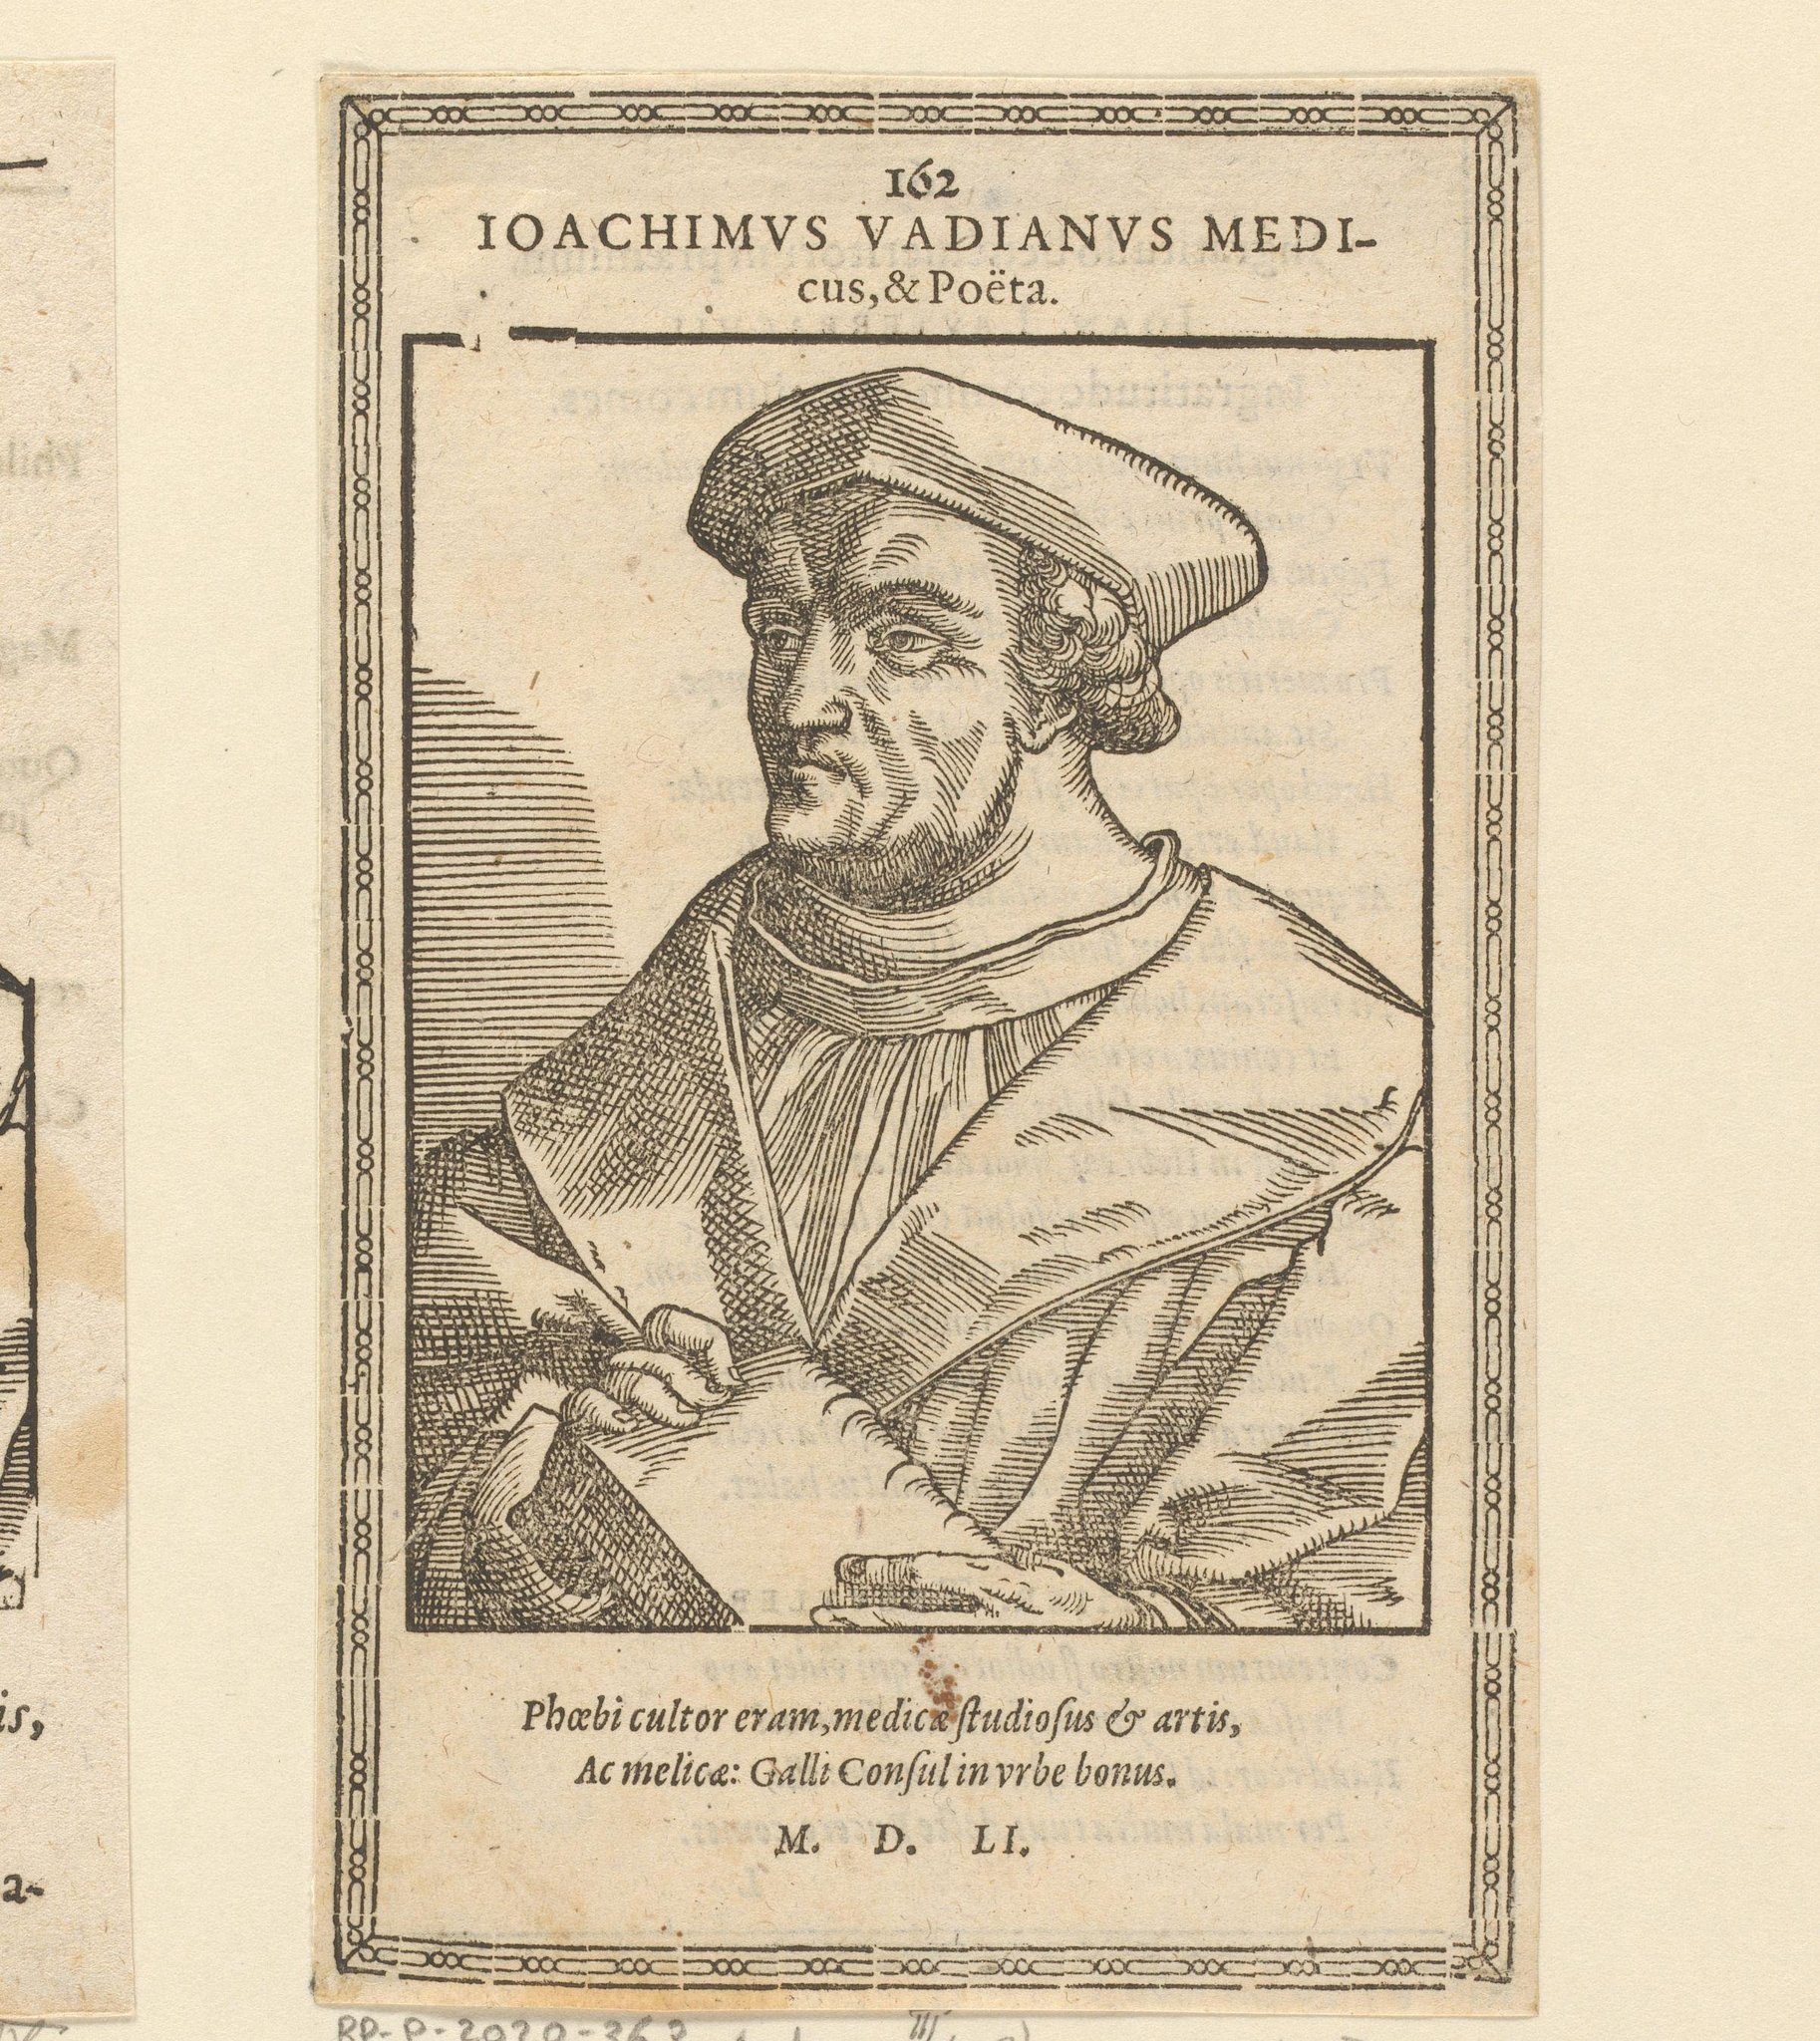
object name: print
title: Portret van Joachim von Watt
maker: bernhard jobin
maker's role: printer, publisher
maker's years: 1545-1593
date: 1590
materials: paper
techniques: letterpress printing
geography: straatsburg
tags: mayor, historical persons, physician, doctor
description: Prent uit: Reusner, Nikolaus. Icones sive imagines virorum literis illustrium (...). Straatsburg: Bernhard Jobin, 1590, p. 162. Prent voor het eerst verschenen in de eerste editie van 1587. Prent ook gebruikt in latere publicaties.